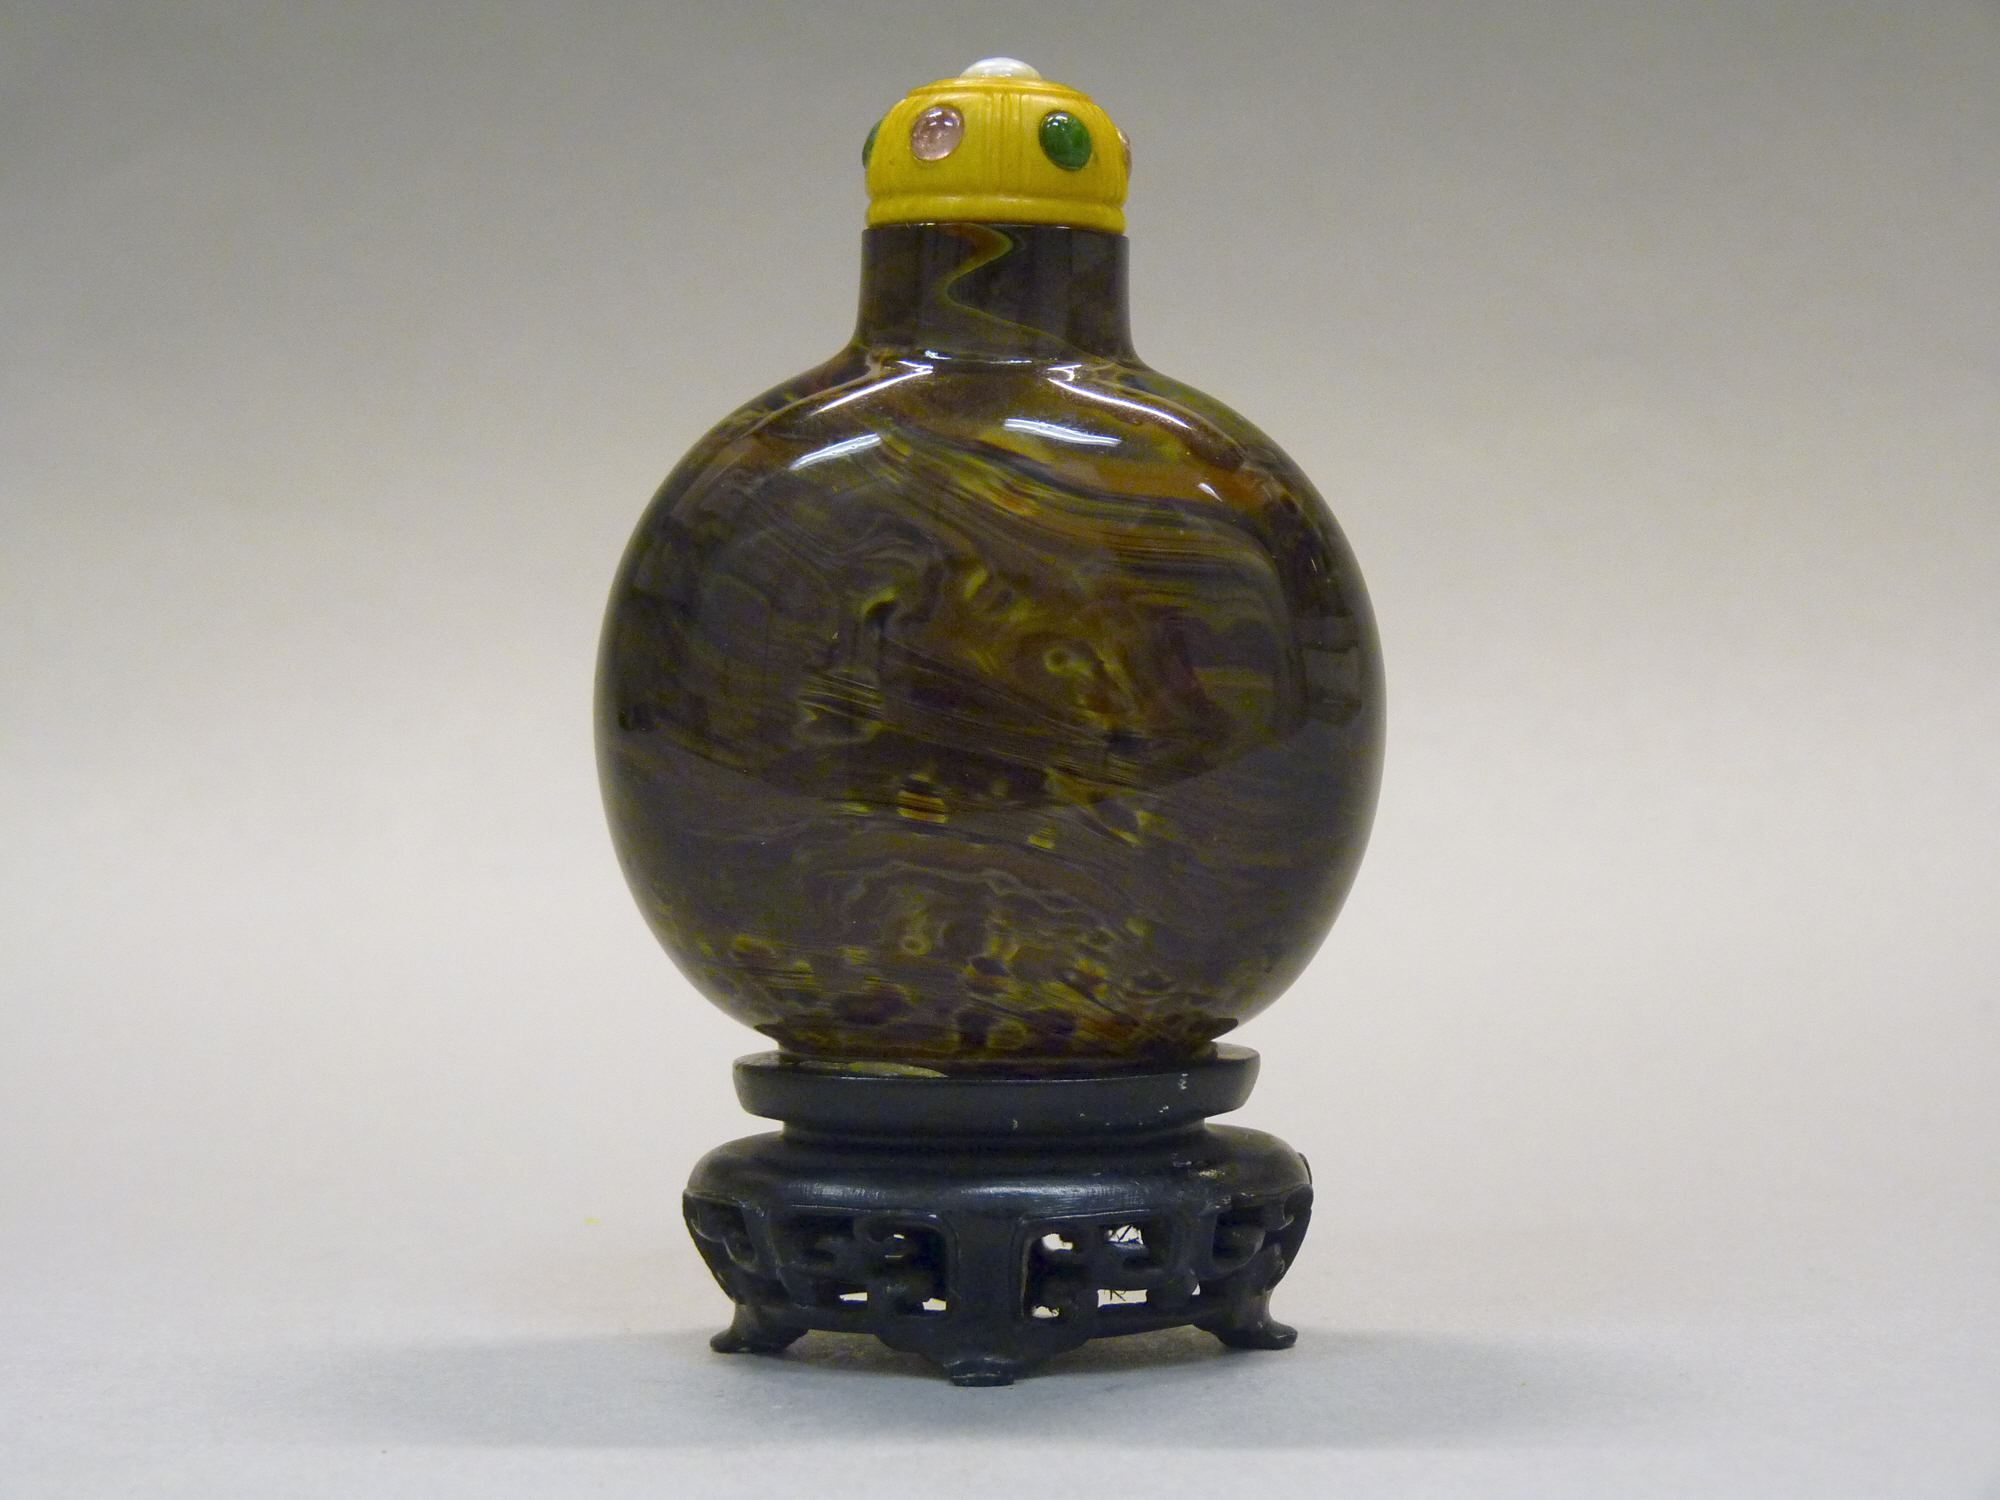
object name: snuff bottle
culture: chinese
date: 1736-1795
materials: glass